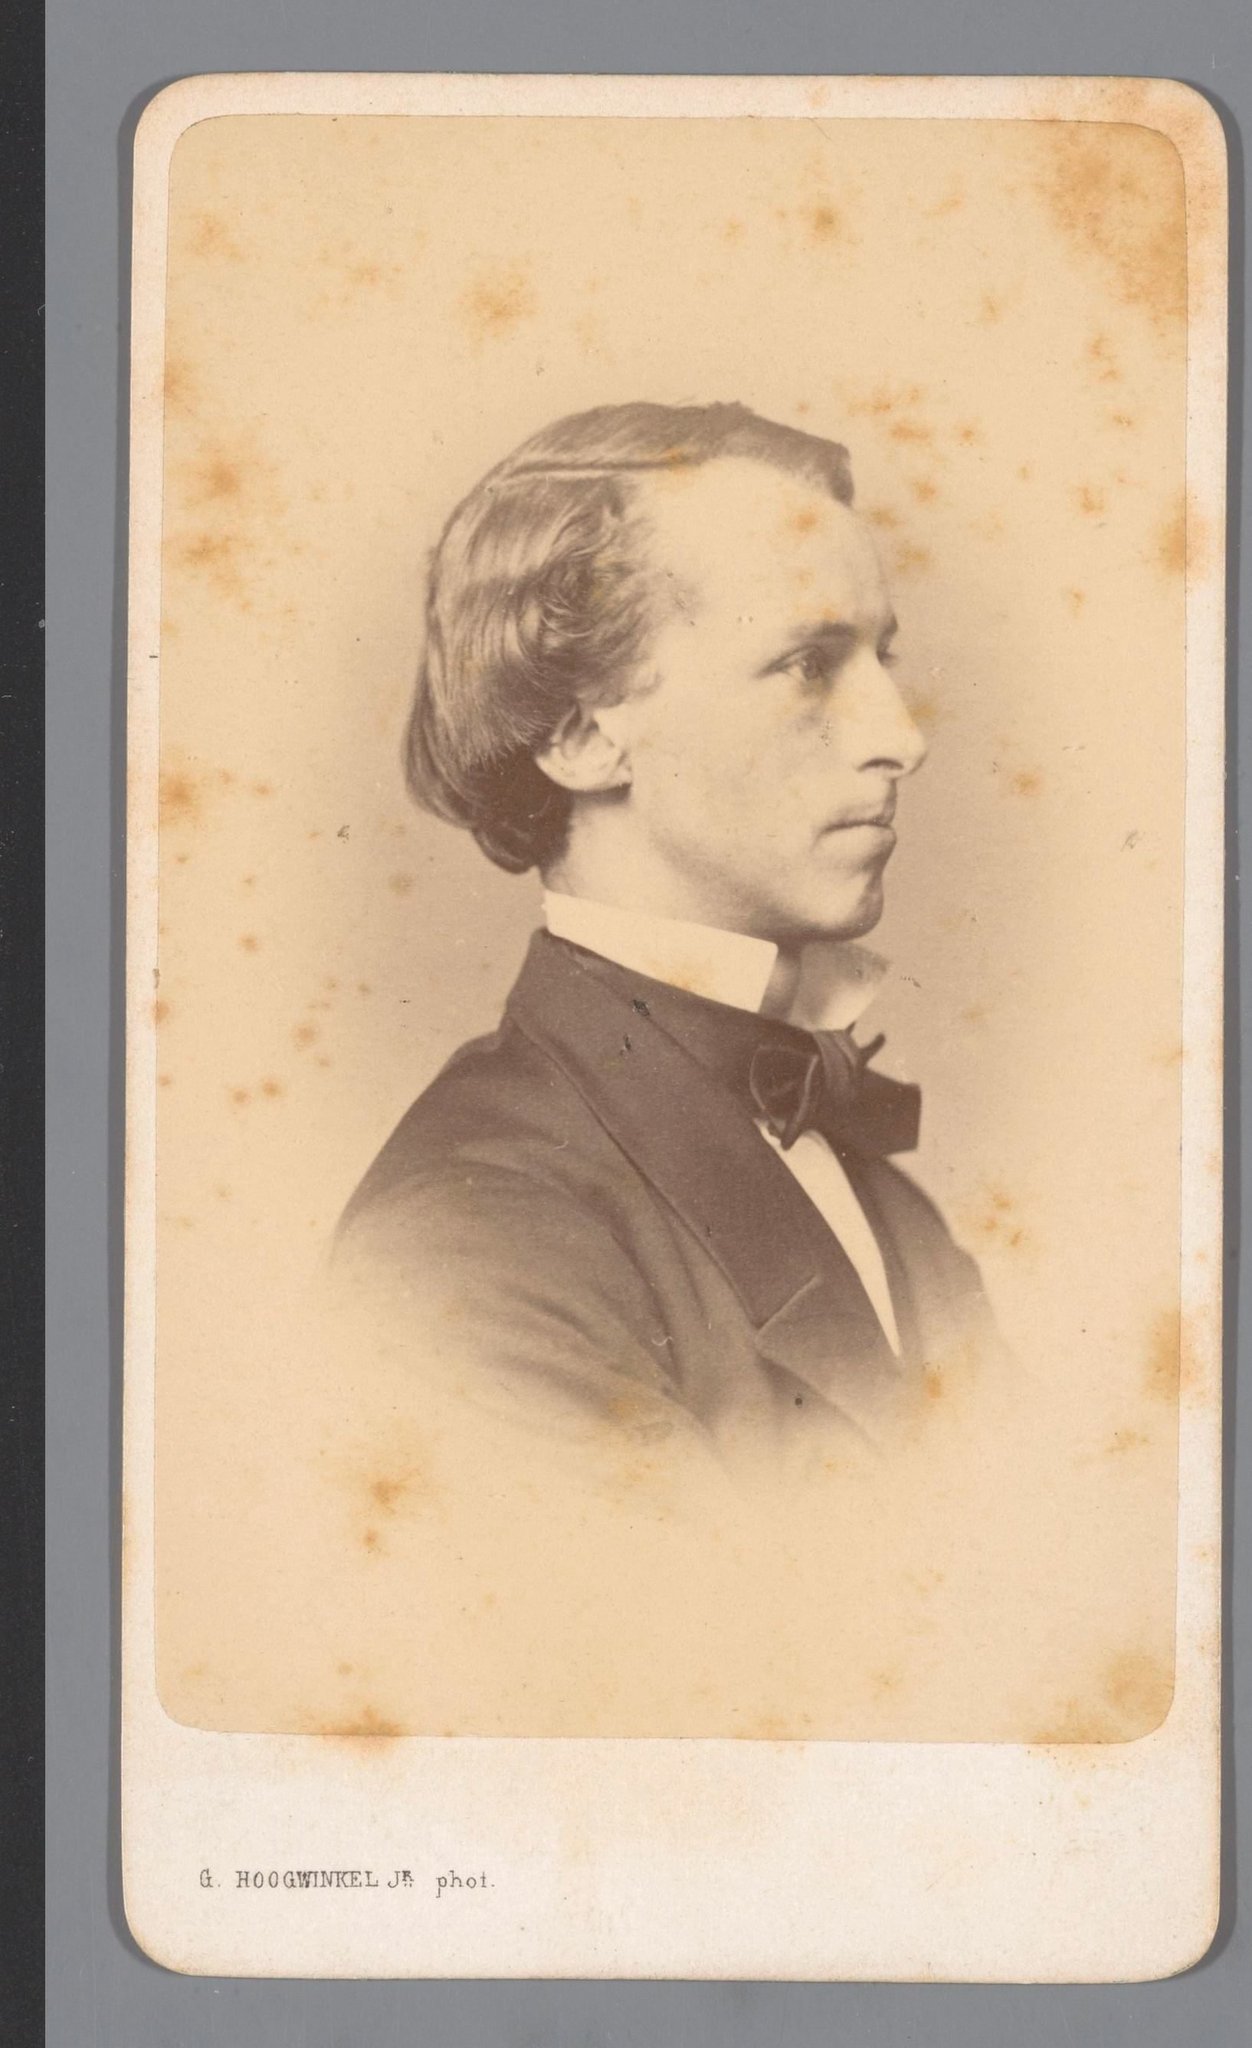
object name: photograph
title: Portret van een man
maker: gerrit hoogwinkel jr.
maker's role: fotograaf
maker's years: 1837-1890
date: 1865-1870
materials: cardboard, paper, photographic support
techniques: albumen print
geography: rotterdam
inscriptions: signature and address: ‘G. Hoogwinkel jr/Photographe/Rotterdam/56, Hoogstraat’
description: Kop van een man, en profiel naar rechts.